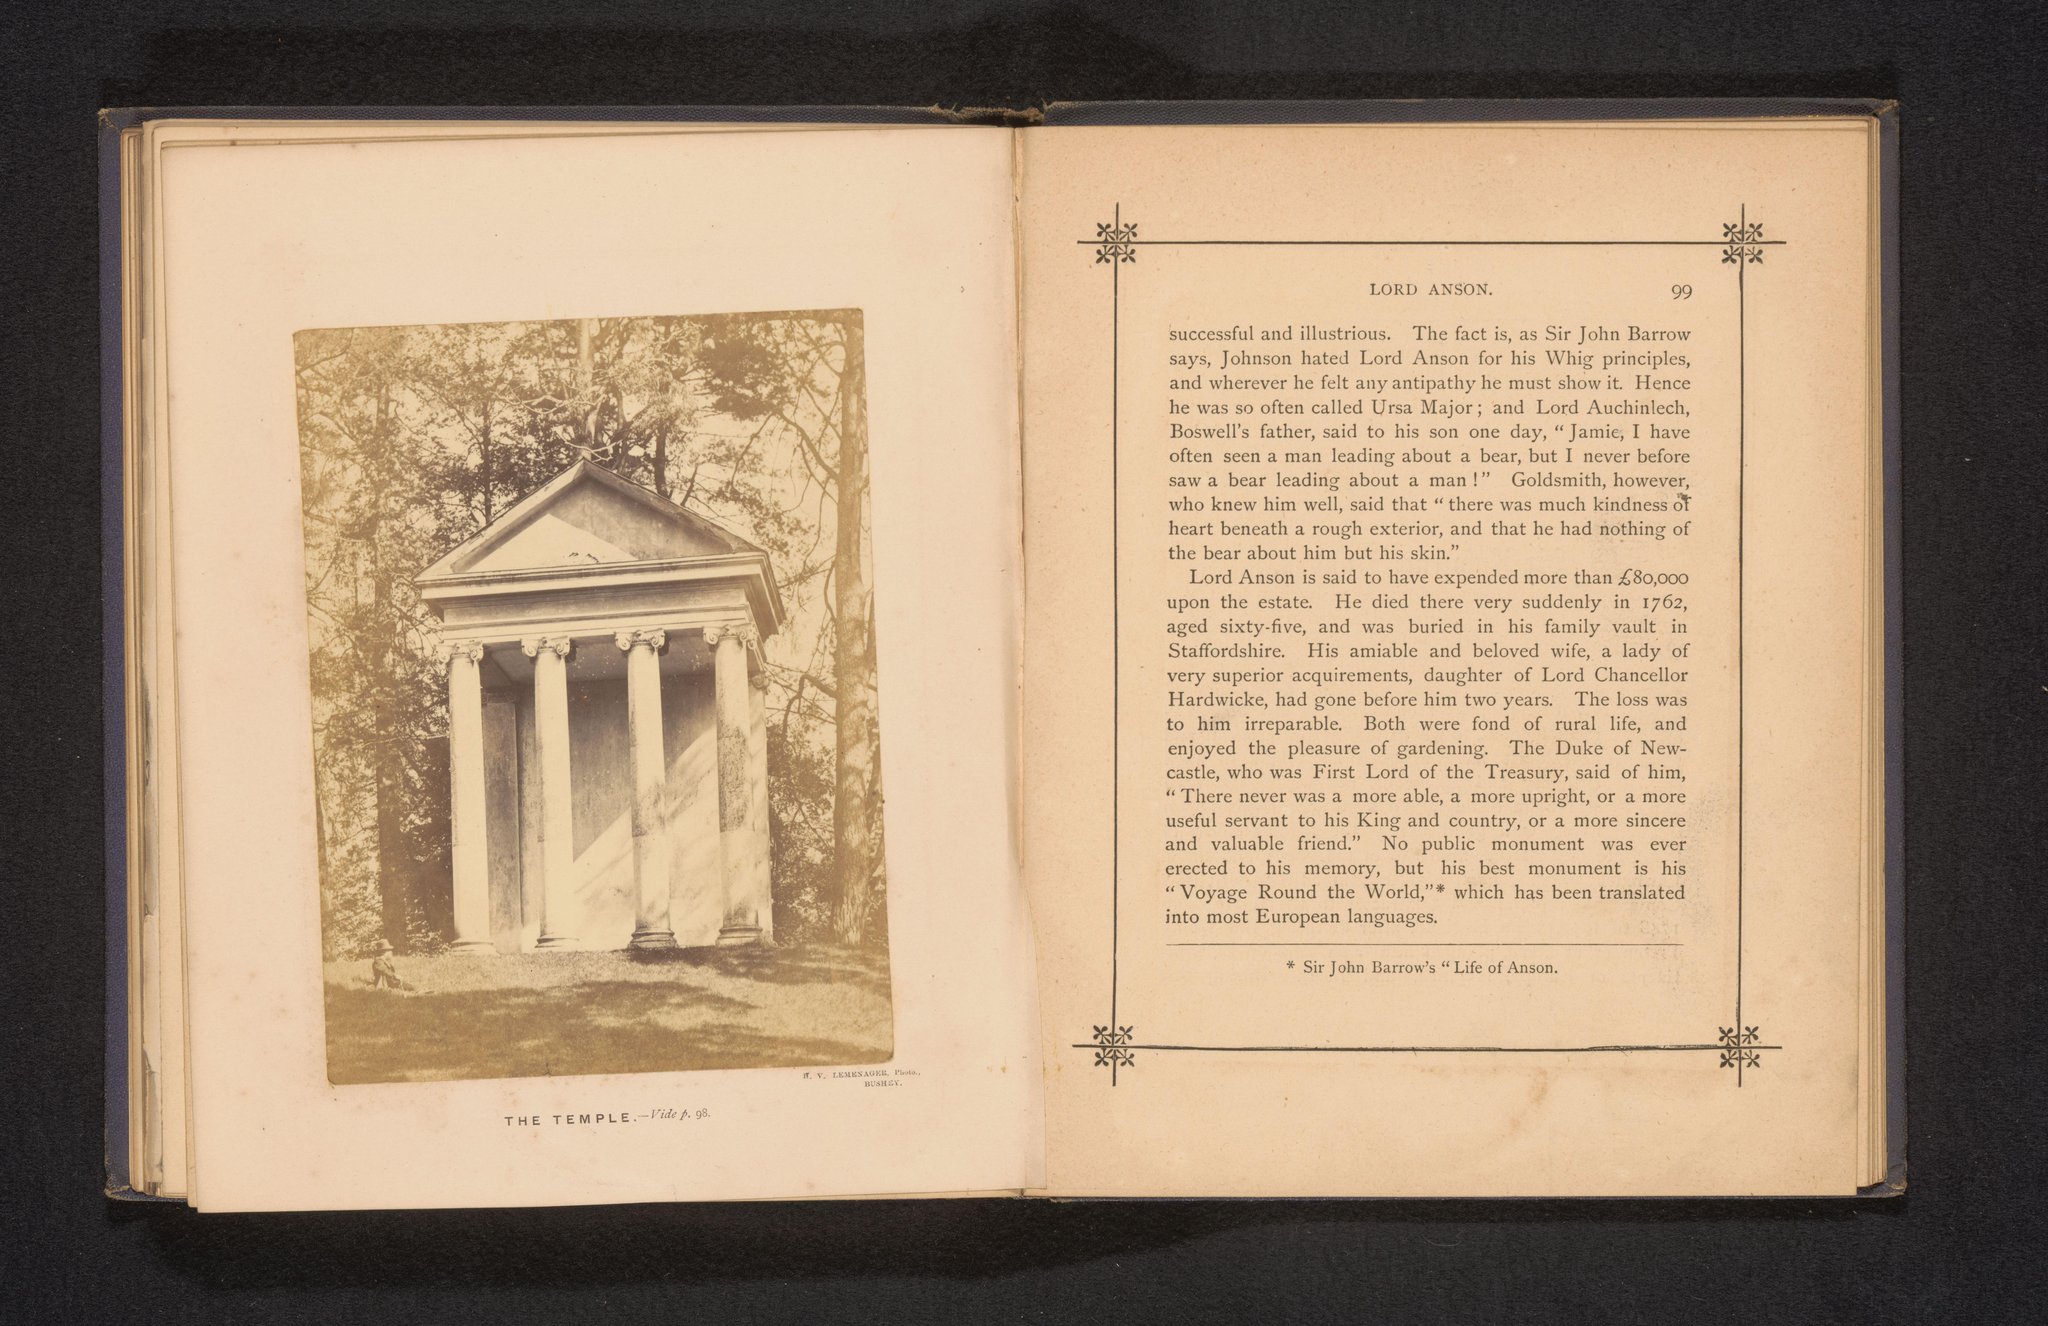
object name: photograph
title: The Temple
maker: henri victor leménager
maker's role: docent, fotograaf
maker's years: 1822-1912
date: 1866-1871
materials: photographic support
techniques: albumen print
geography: rickmansworth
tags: park, temple, shrine ~ roman religion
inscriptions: inscription: ‘Vide p. 98.’